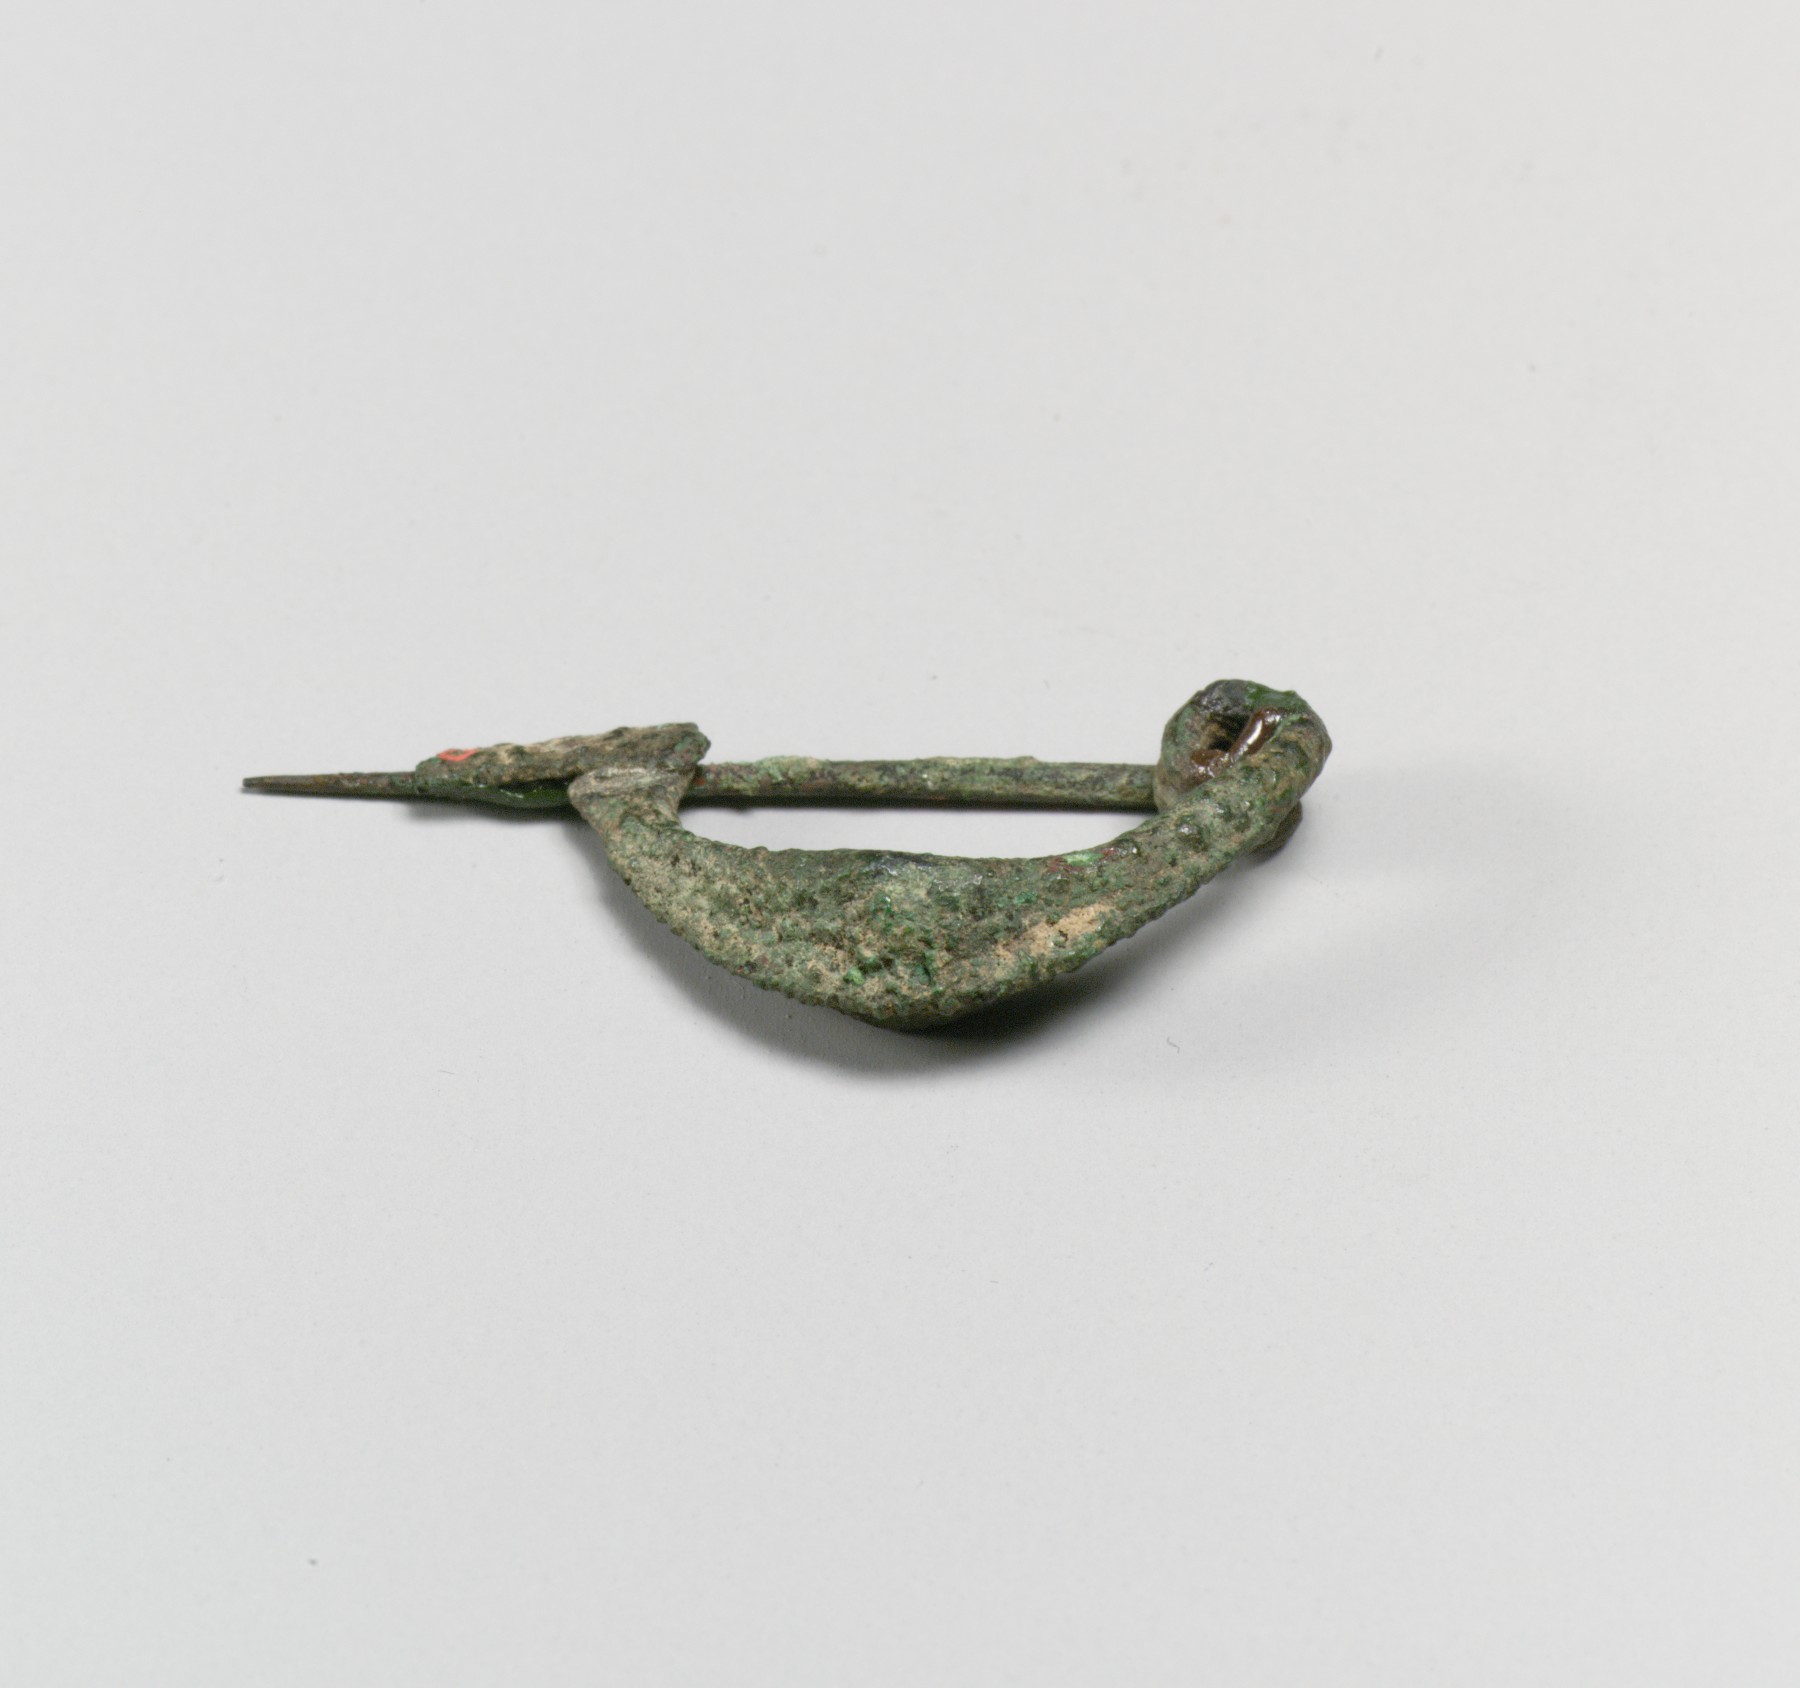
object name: fibula, boat shaped type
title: Fibula, boat-shaped type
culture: italic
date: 800-501 BCE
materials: bronze